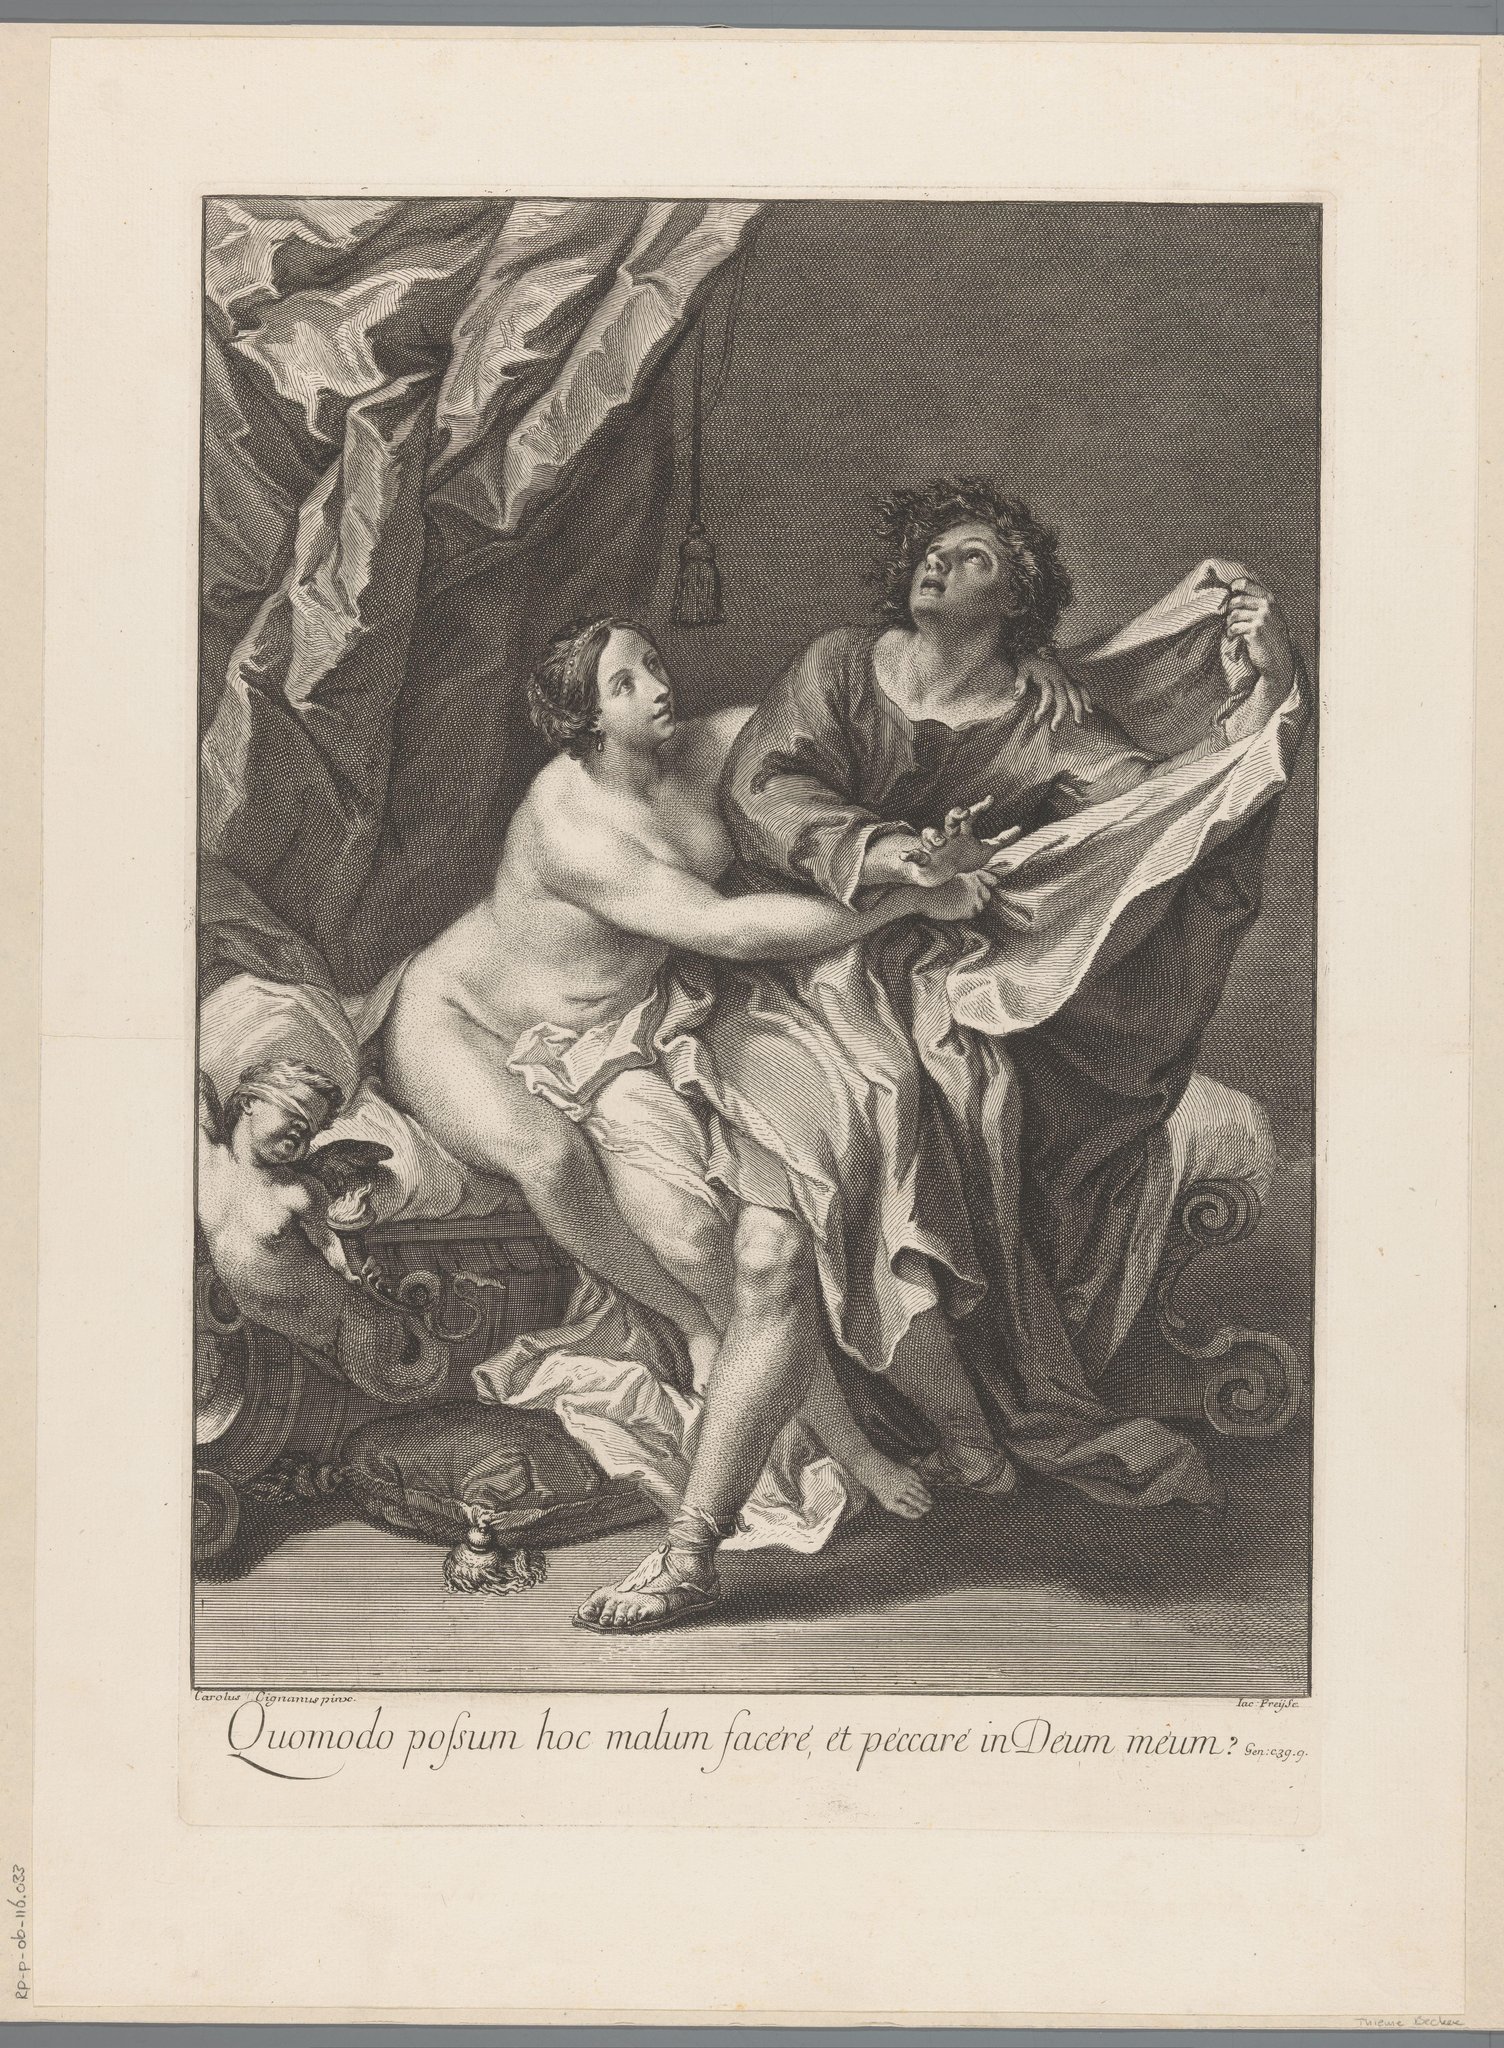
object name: print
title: Jozef en de vrouw van Potifar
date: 1720-1722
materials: paper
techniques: engraving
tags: potiphar's wife catches joseph by his robe, usually while lying in bed; joseph escapes leaving his cloak behind in her hands (possibly with a naked child lying in a crib)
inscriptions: collector's mark: Lugt 240